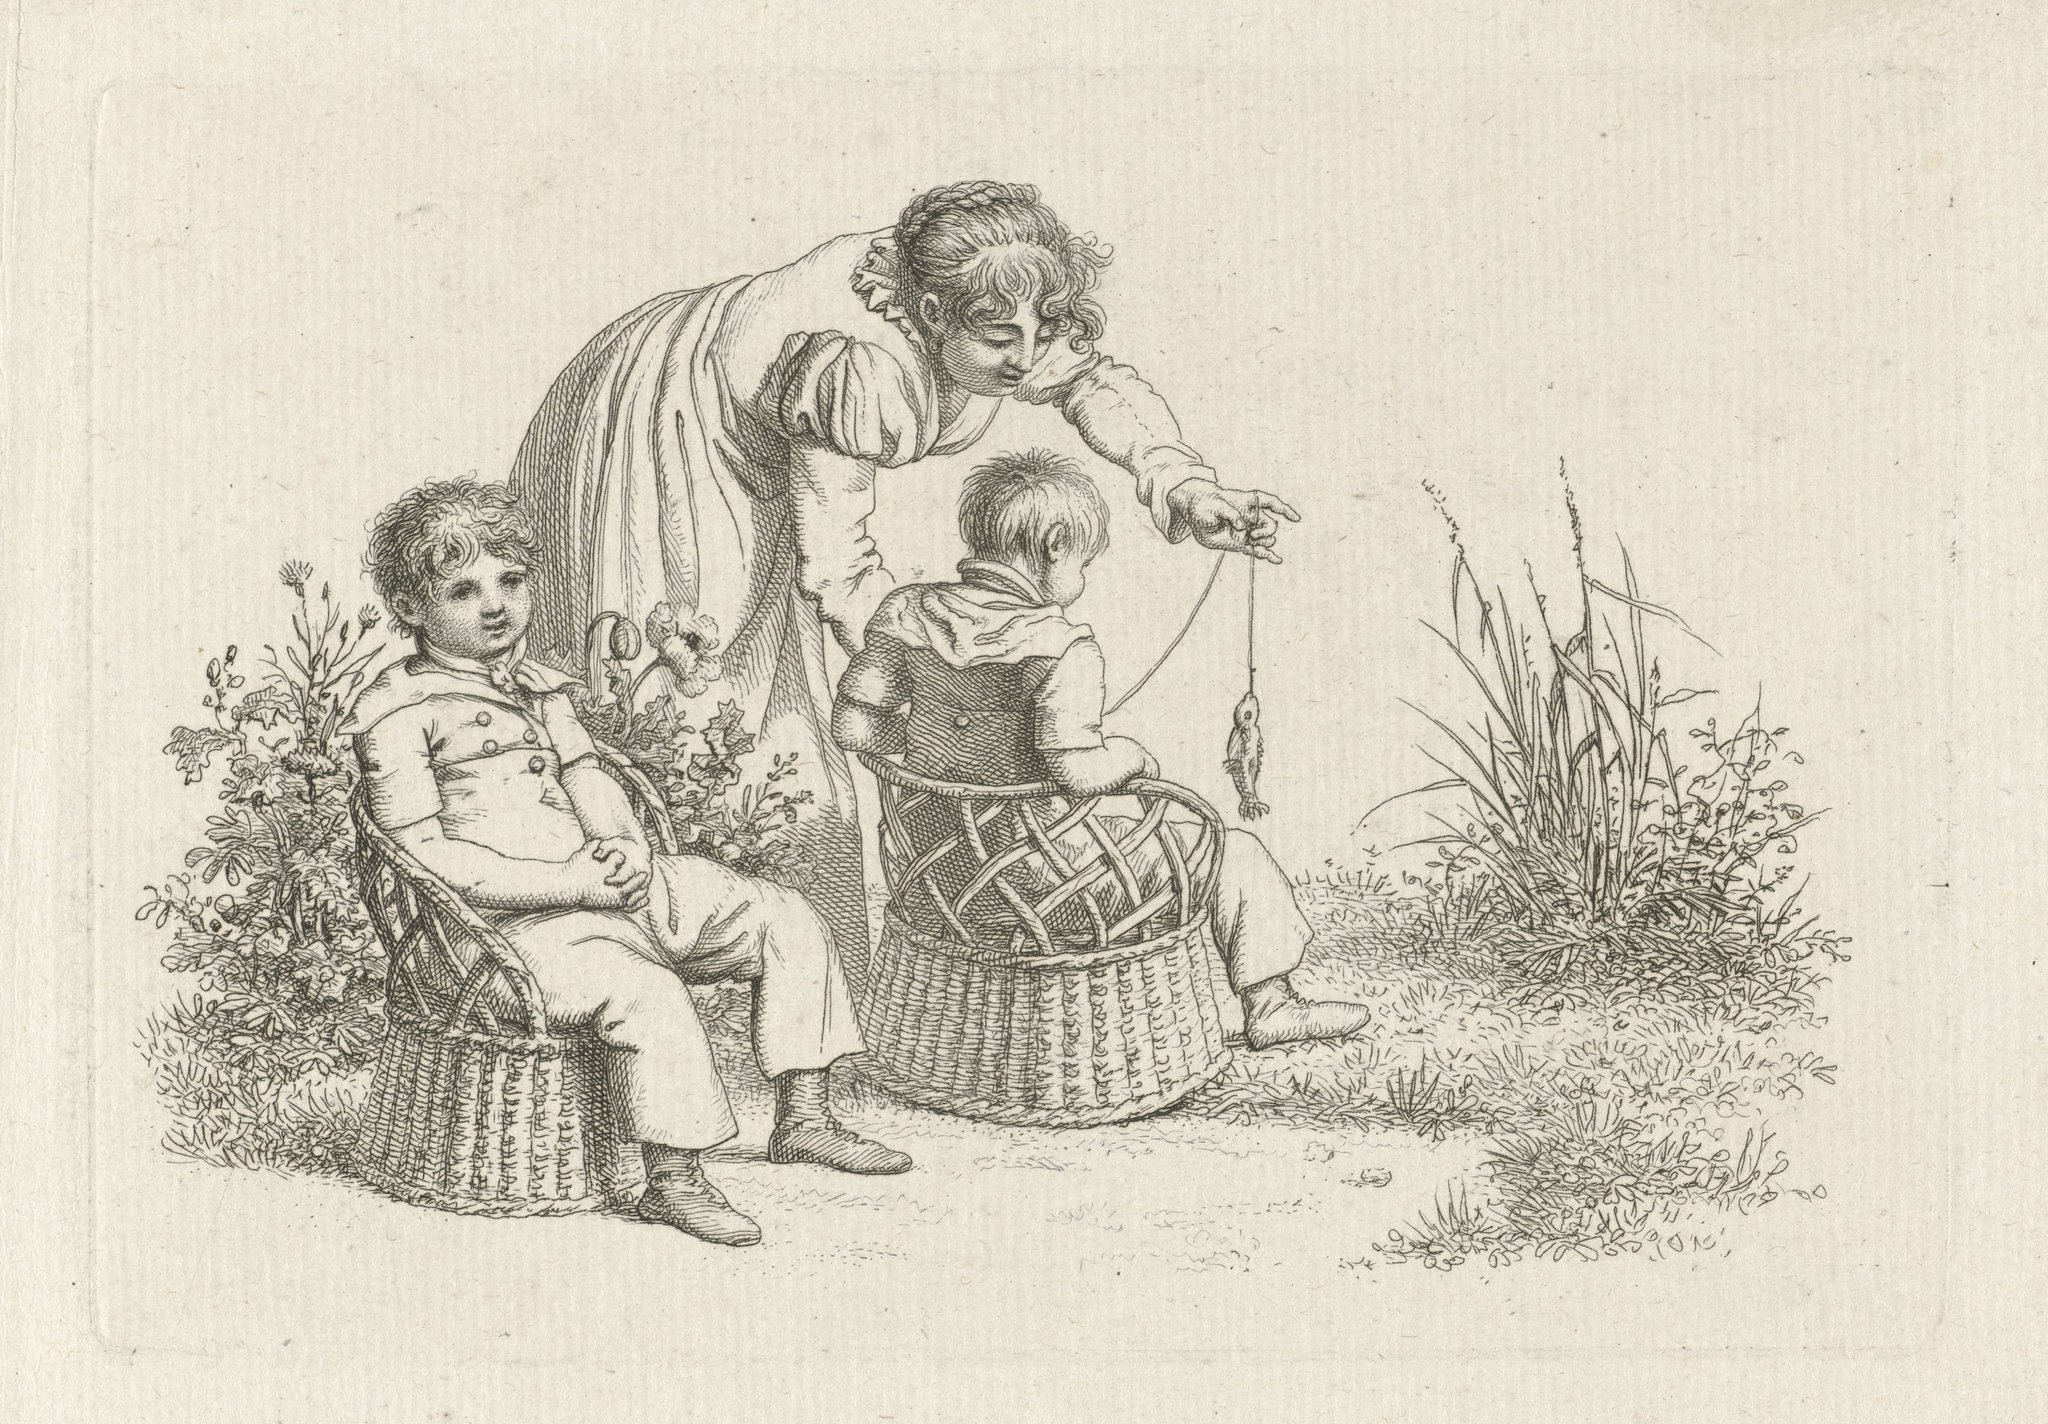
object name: print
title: Studie-prentwerk / Etudes gravées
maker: jacob ernst marcus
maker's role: draughtsman, print maker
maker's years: 1774-1826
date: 1808-1812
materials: paper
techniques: etching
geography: amsterdam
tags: child, fishing (sports), mother with son(s) (mother-love), chair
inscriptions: collector's mark: Lugt 2228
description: Serie voor het eerst uitgegeven door Jacob Ernst Marcus onder de titel Studiebeelden en Fragmenten. Amsterdam: ca.1816. Later heruitgegeven als: Studie-prentwerk/ Etudes gravées.